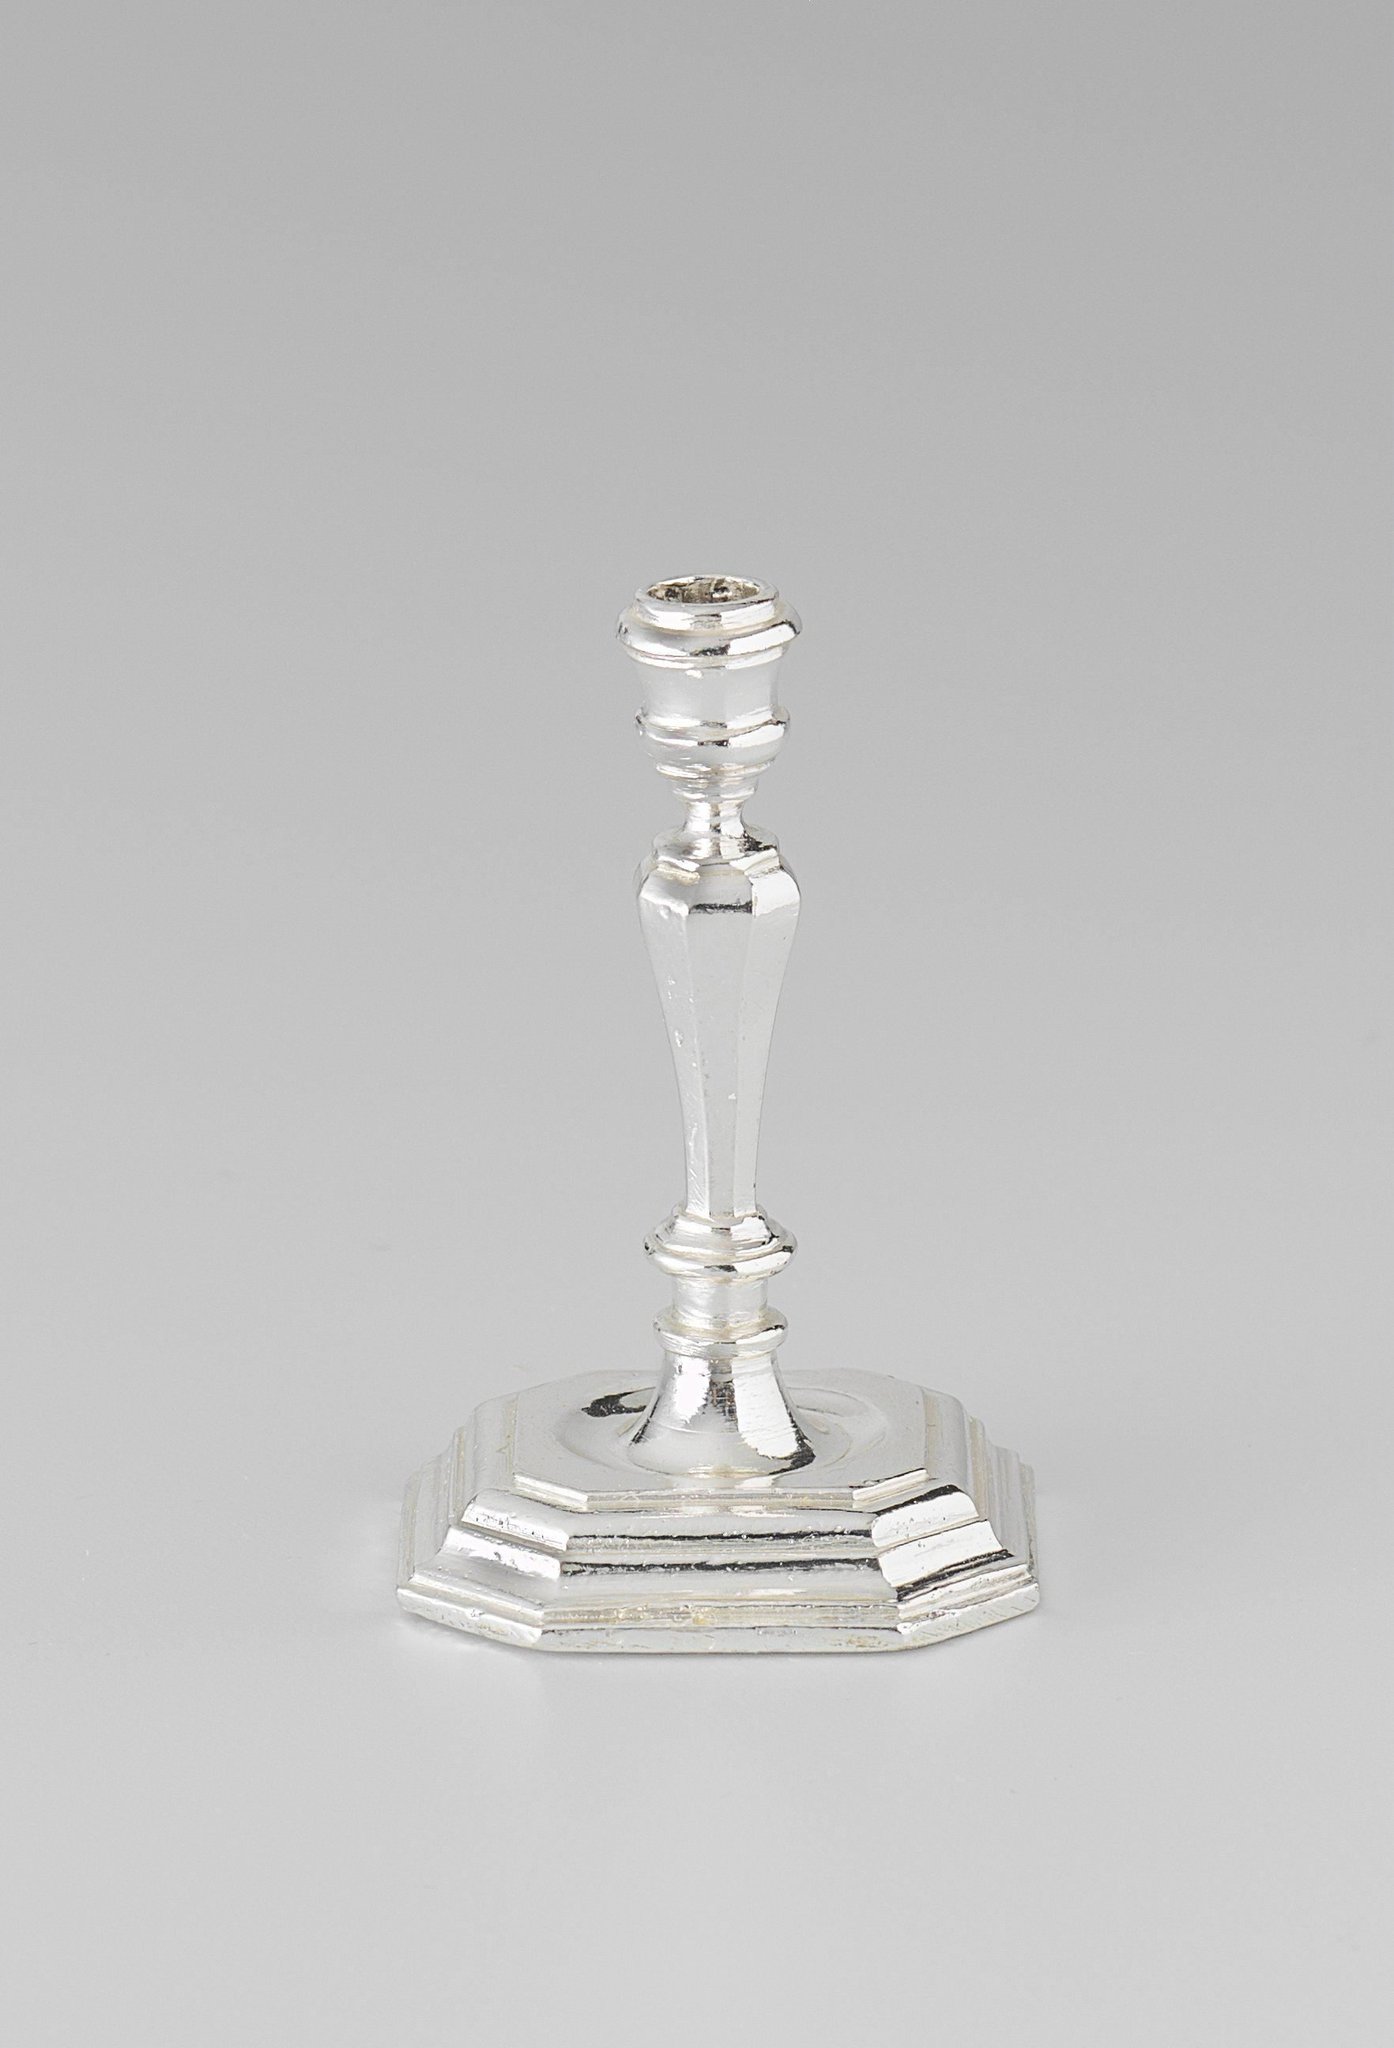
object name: miniature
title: Kandelaar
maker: Anonymous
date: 1704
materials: silver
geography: netherlands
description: Kandelaar op vierkante, afgekante voet. De stam is meerkantig, geprofileerd en balustervormig. De kandelaar is gemerkt: stk.= Amsterdam en een onbekend meesterteken. Bij de kandelaar hoort een identieke kandelaar (invnr. BK-NM-11177-139).